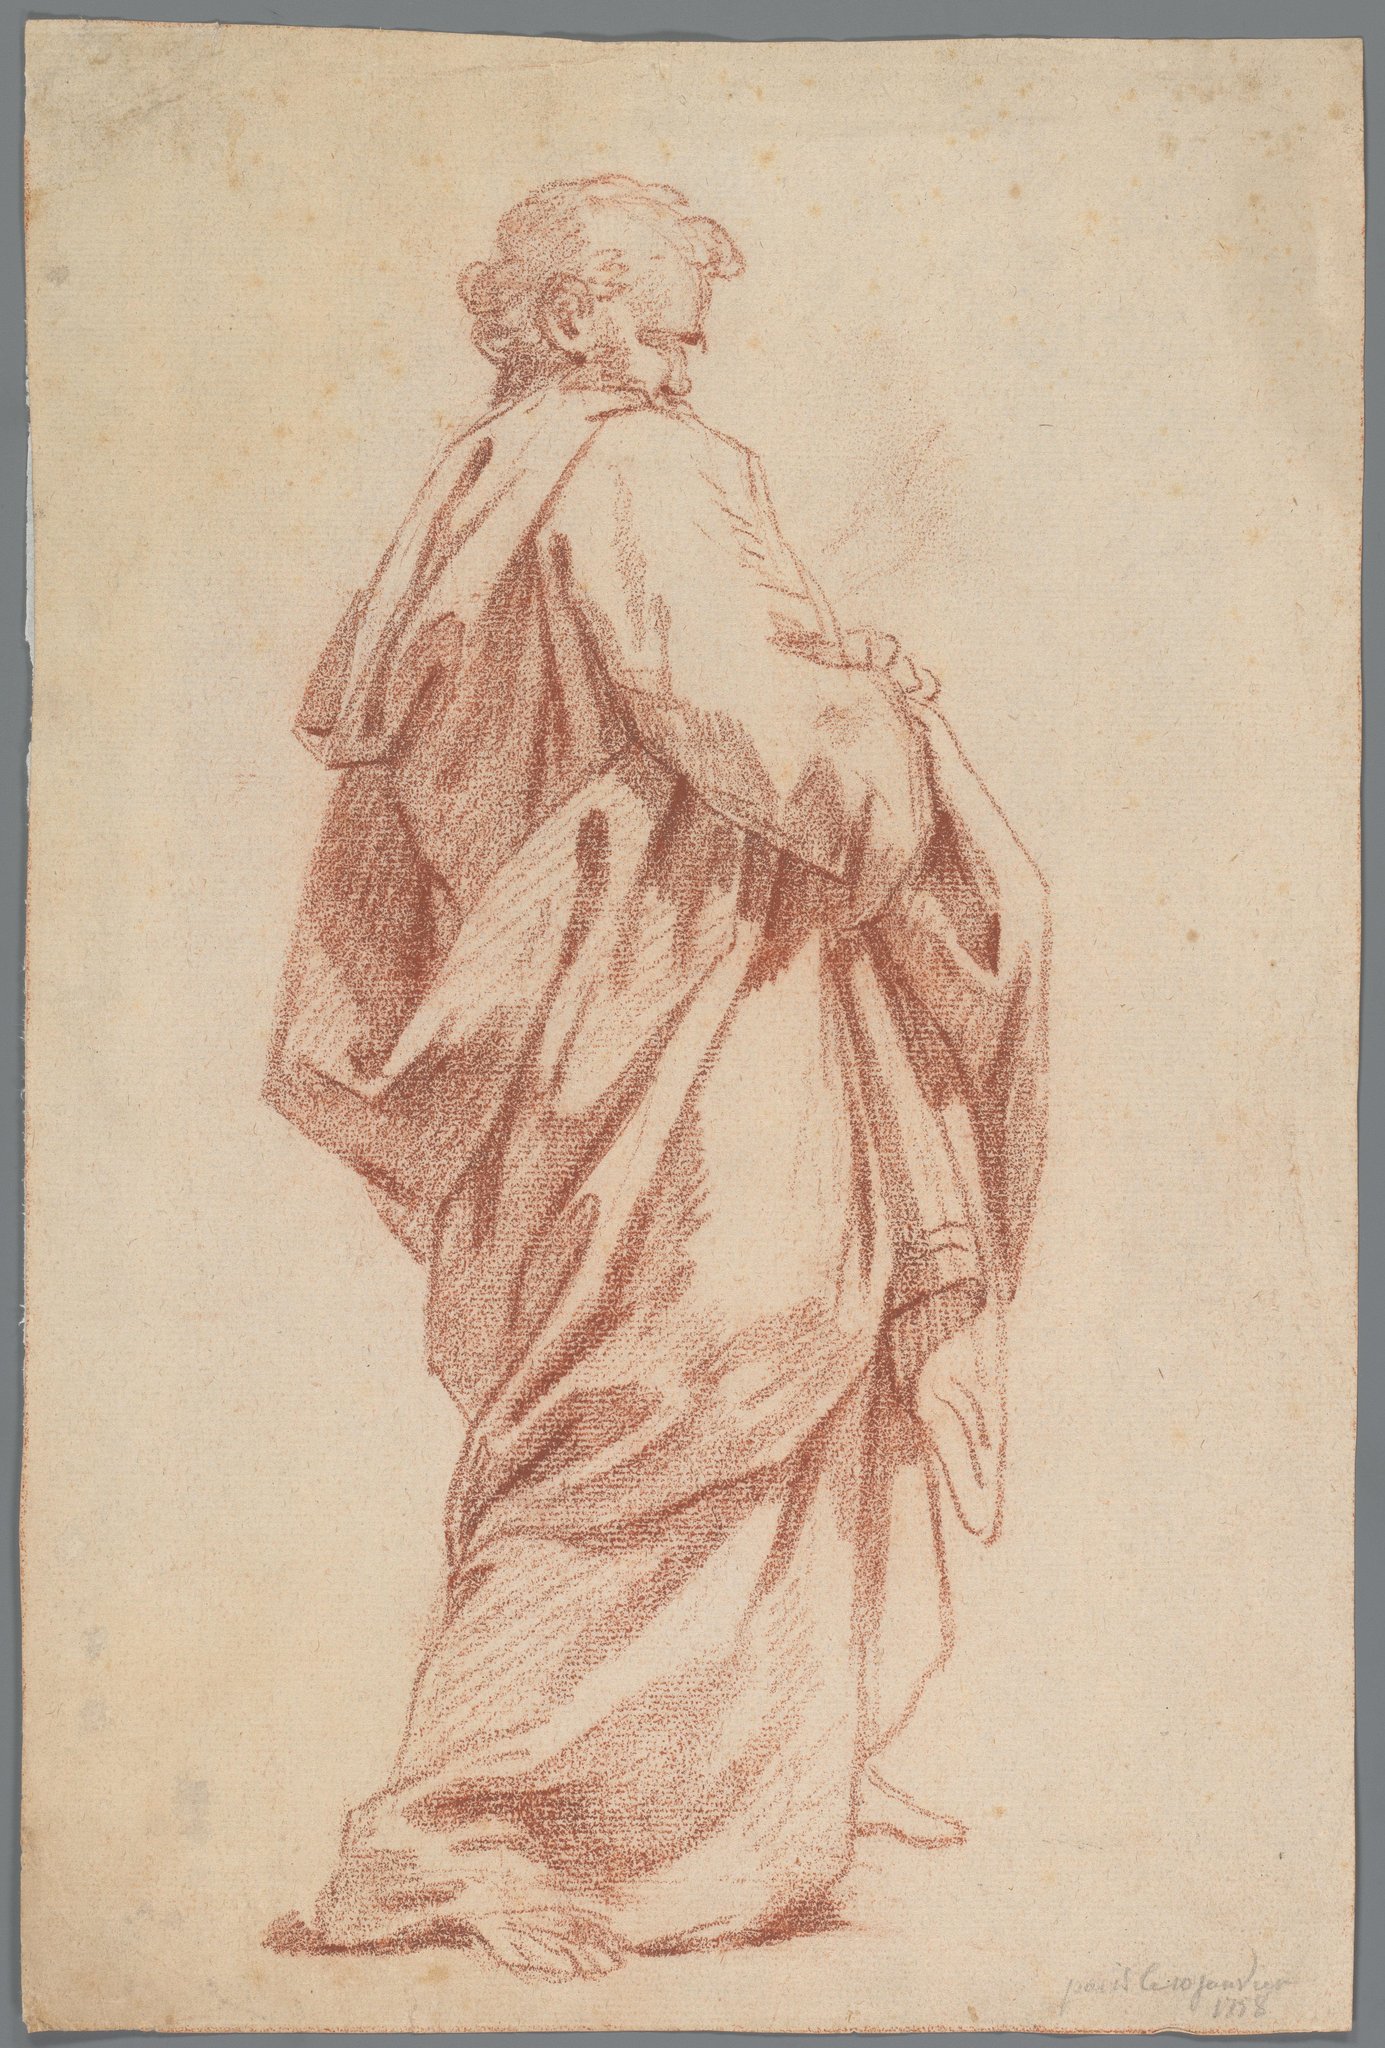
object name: drawing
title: Studie van een in lange mantel gedrapeerd model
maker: Anonymous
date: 1758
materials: chalk, paper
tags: standing figure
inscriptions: date: ‘paris le 20 janvier / 17[4/5?]8’